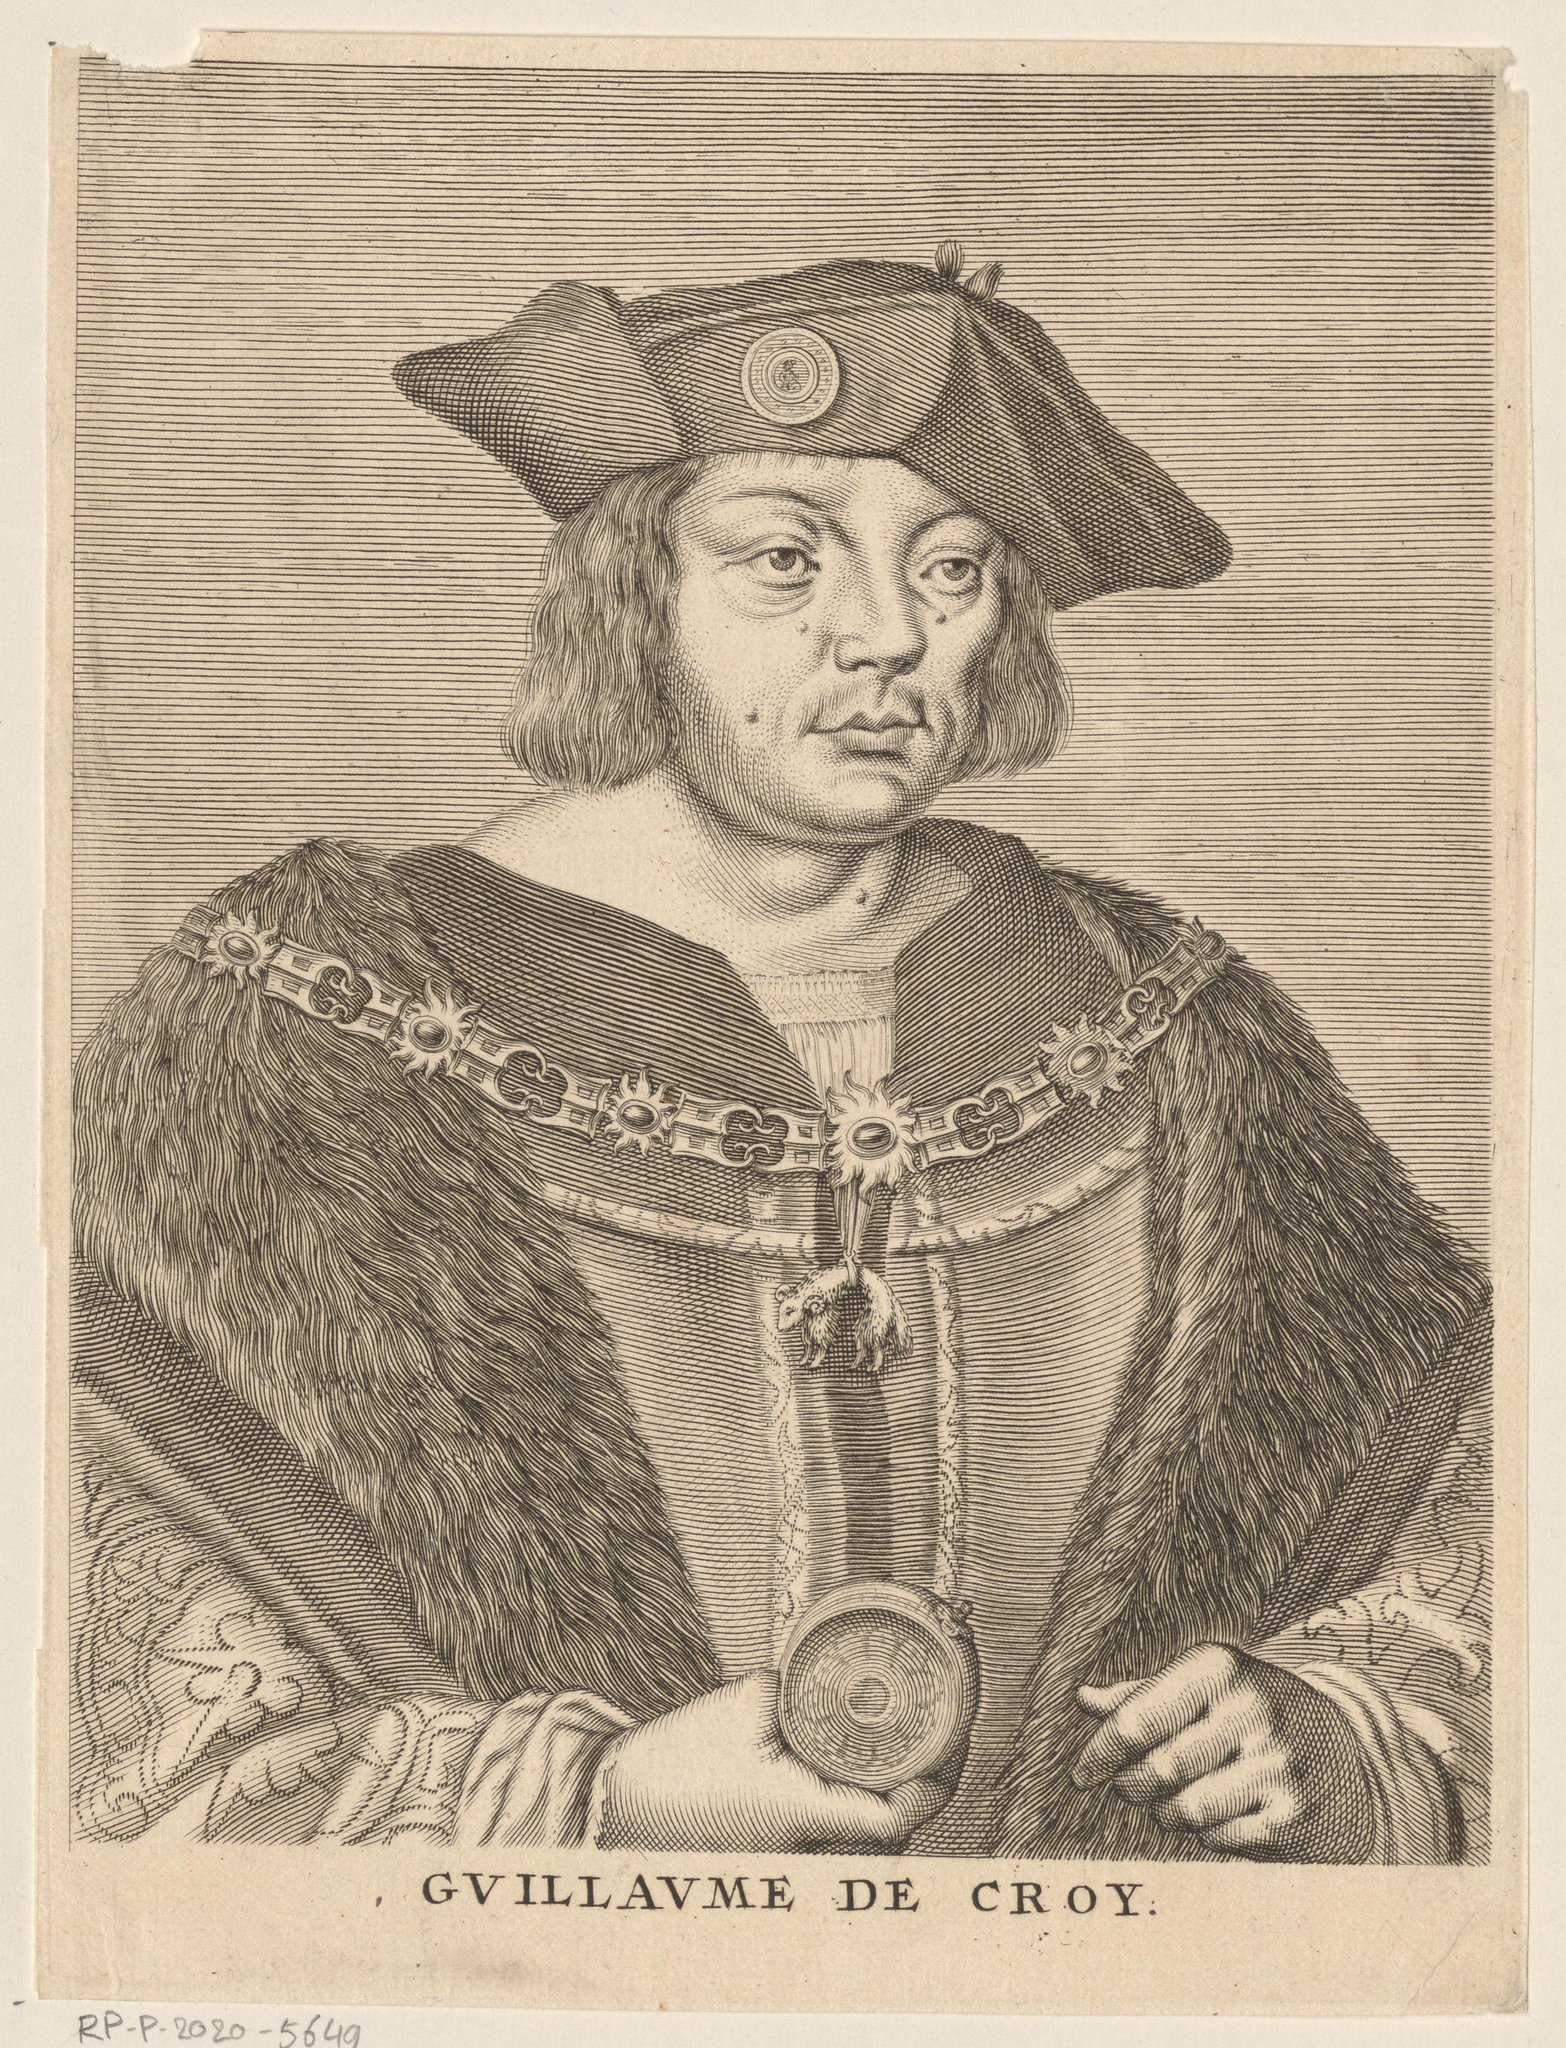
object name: print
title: Portret van Willem van Croÿ II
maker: Anonymous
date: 1682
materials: paper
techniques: engraving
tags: historical persons, armorial bearing, heraldry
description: Prent met tekst op verso gebruikt in: Bullart, Isaac. Academie des sciences et des arts (...). Amsterdam: Daniel Elzevier, 1682, dl. 1.